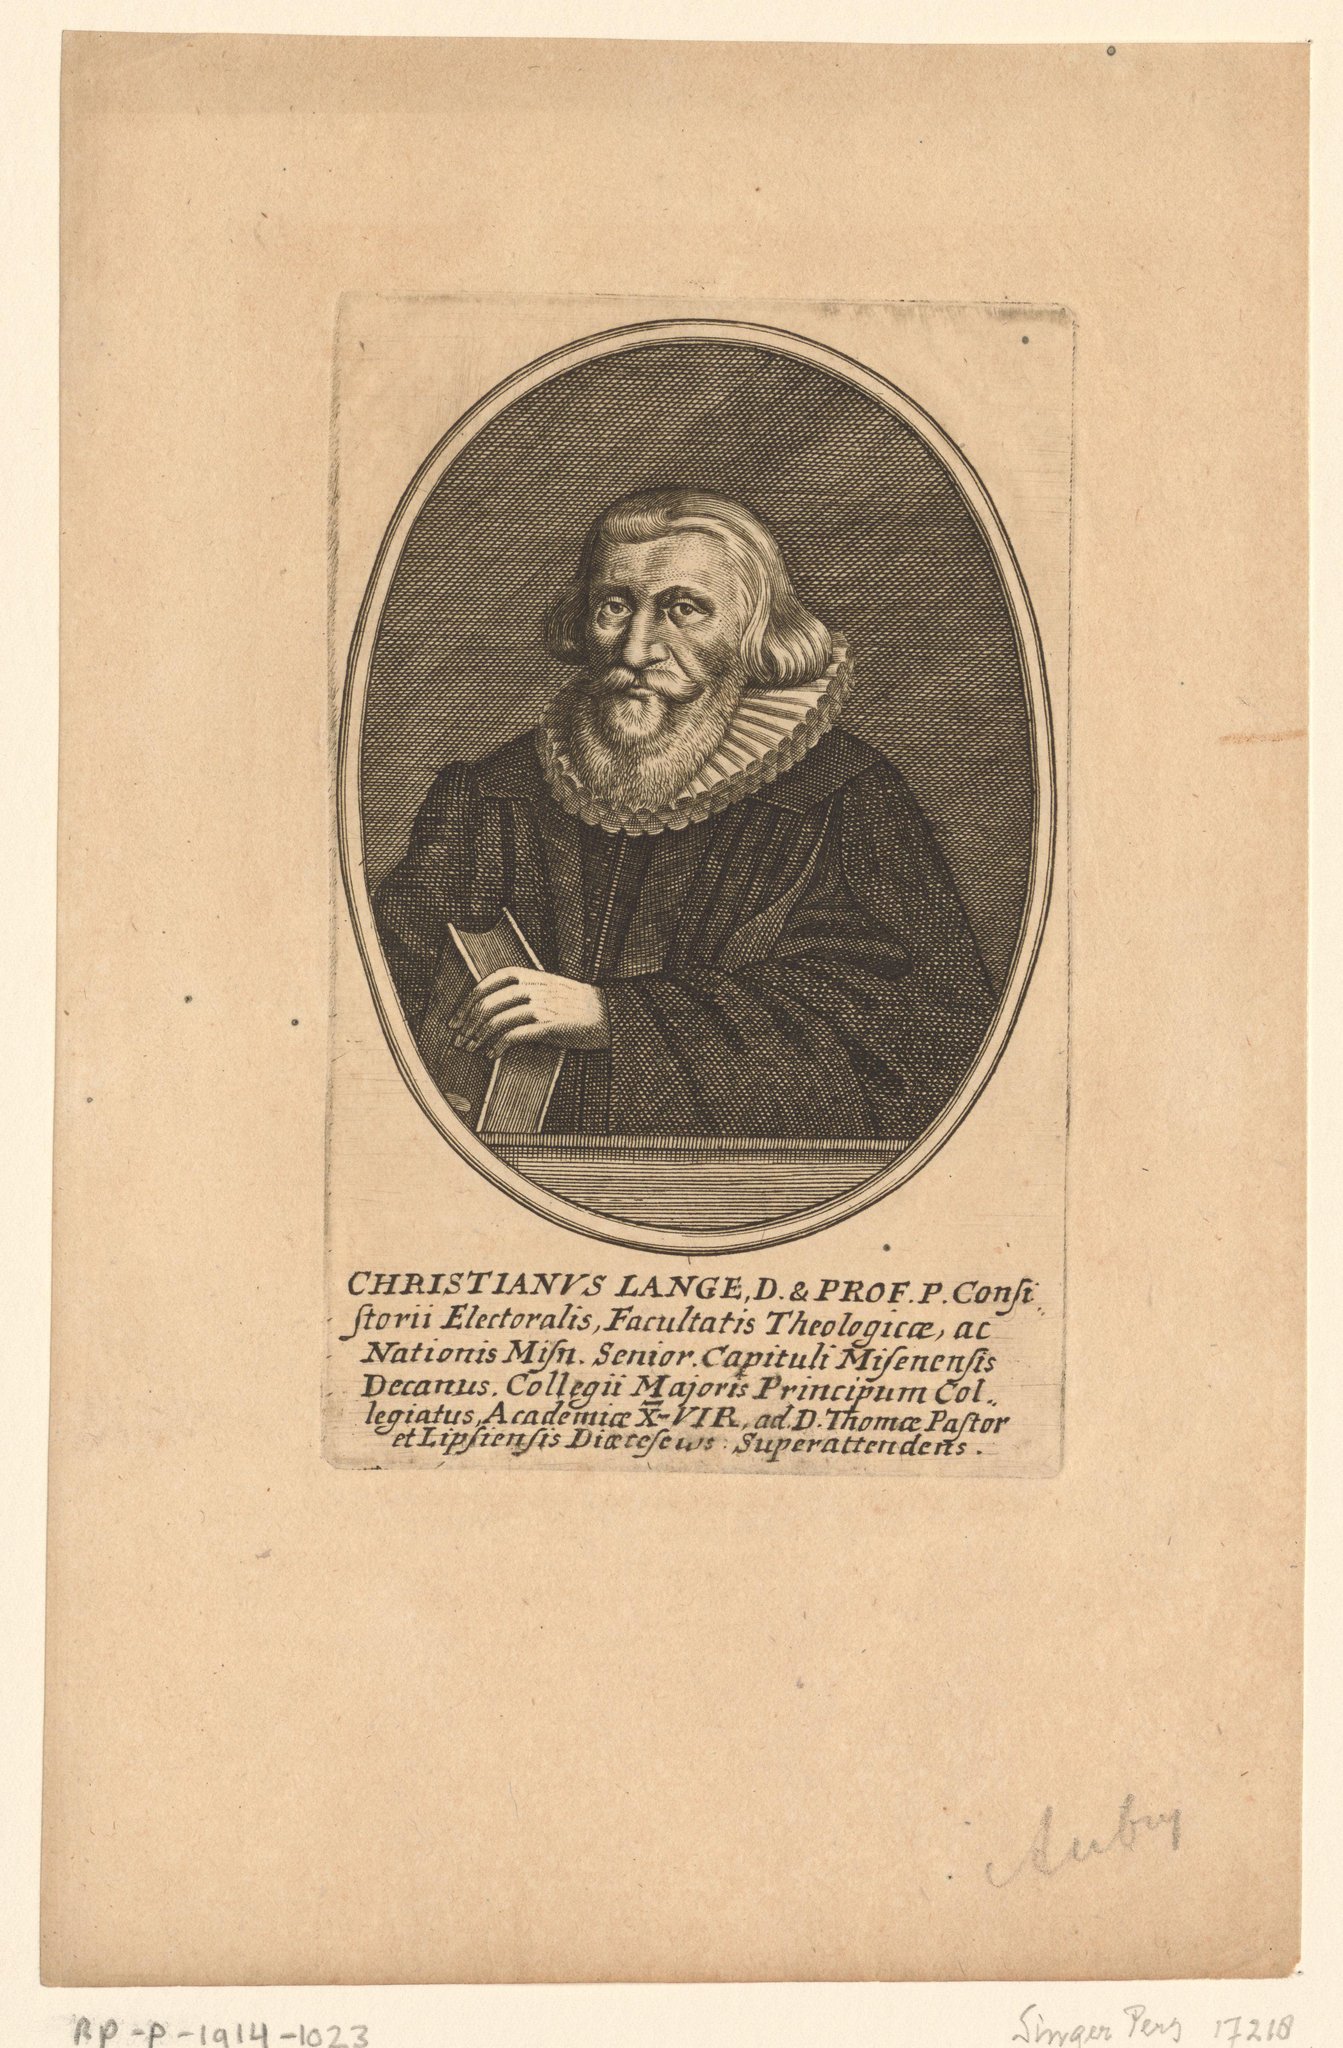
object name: print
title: Portret van Christian Lange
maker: peter aubry (iii)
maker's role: print maker, publisher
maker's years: 1610-1686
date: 1635-1686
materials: paper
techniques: engraving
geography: straatsburg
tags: theologian, historical persons, book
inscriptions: collector's mark: Lugt 2228